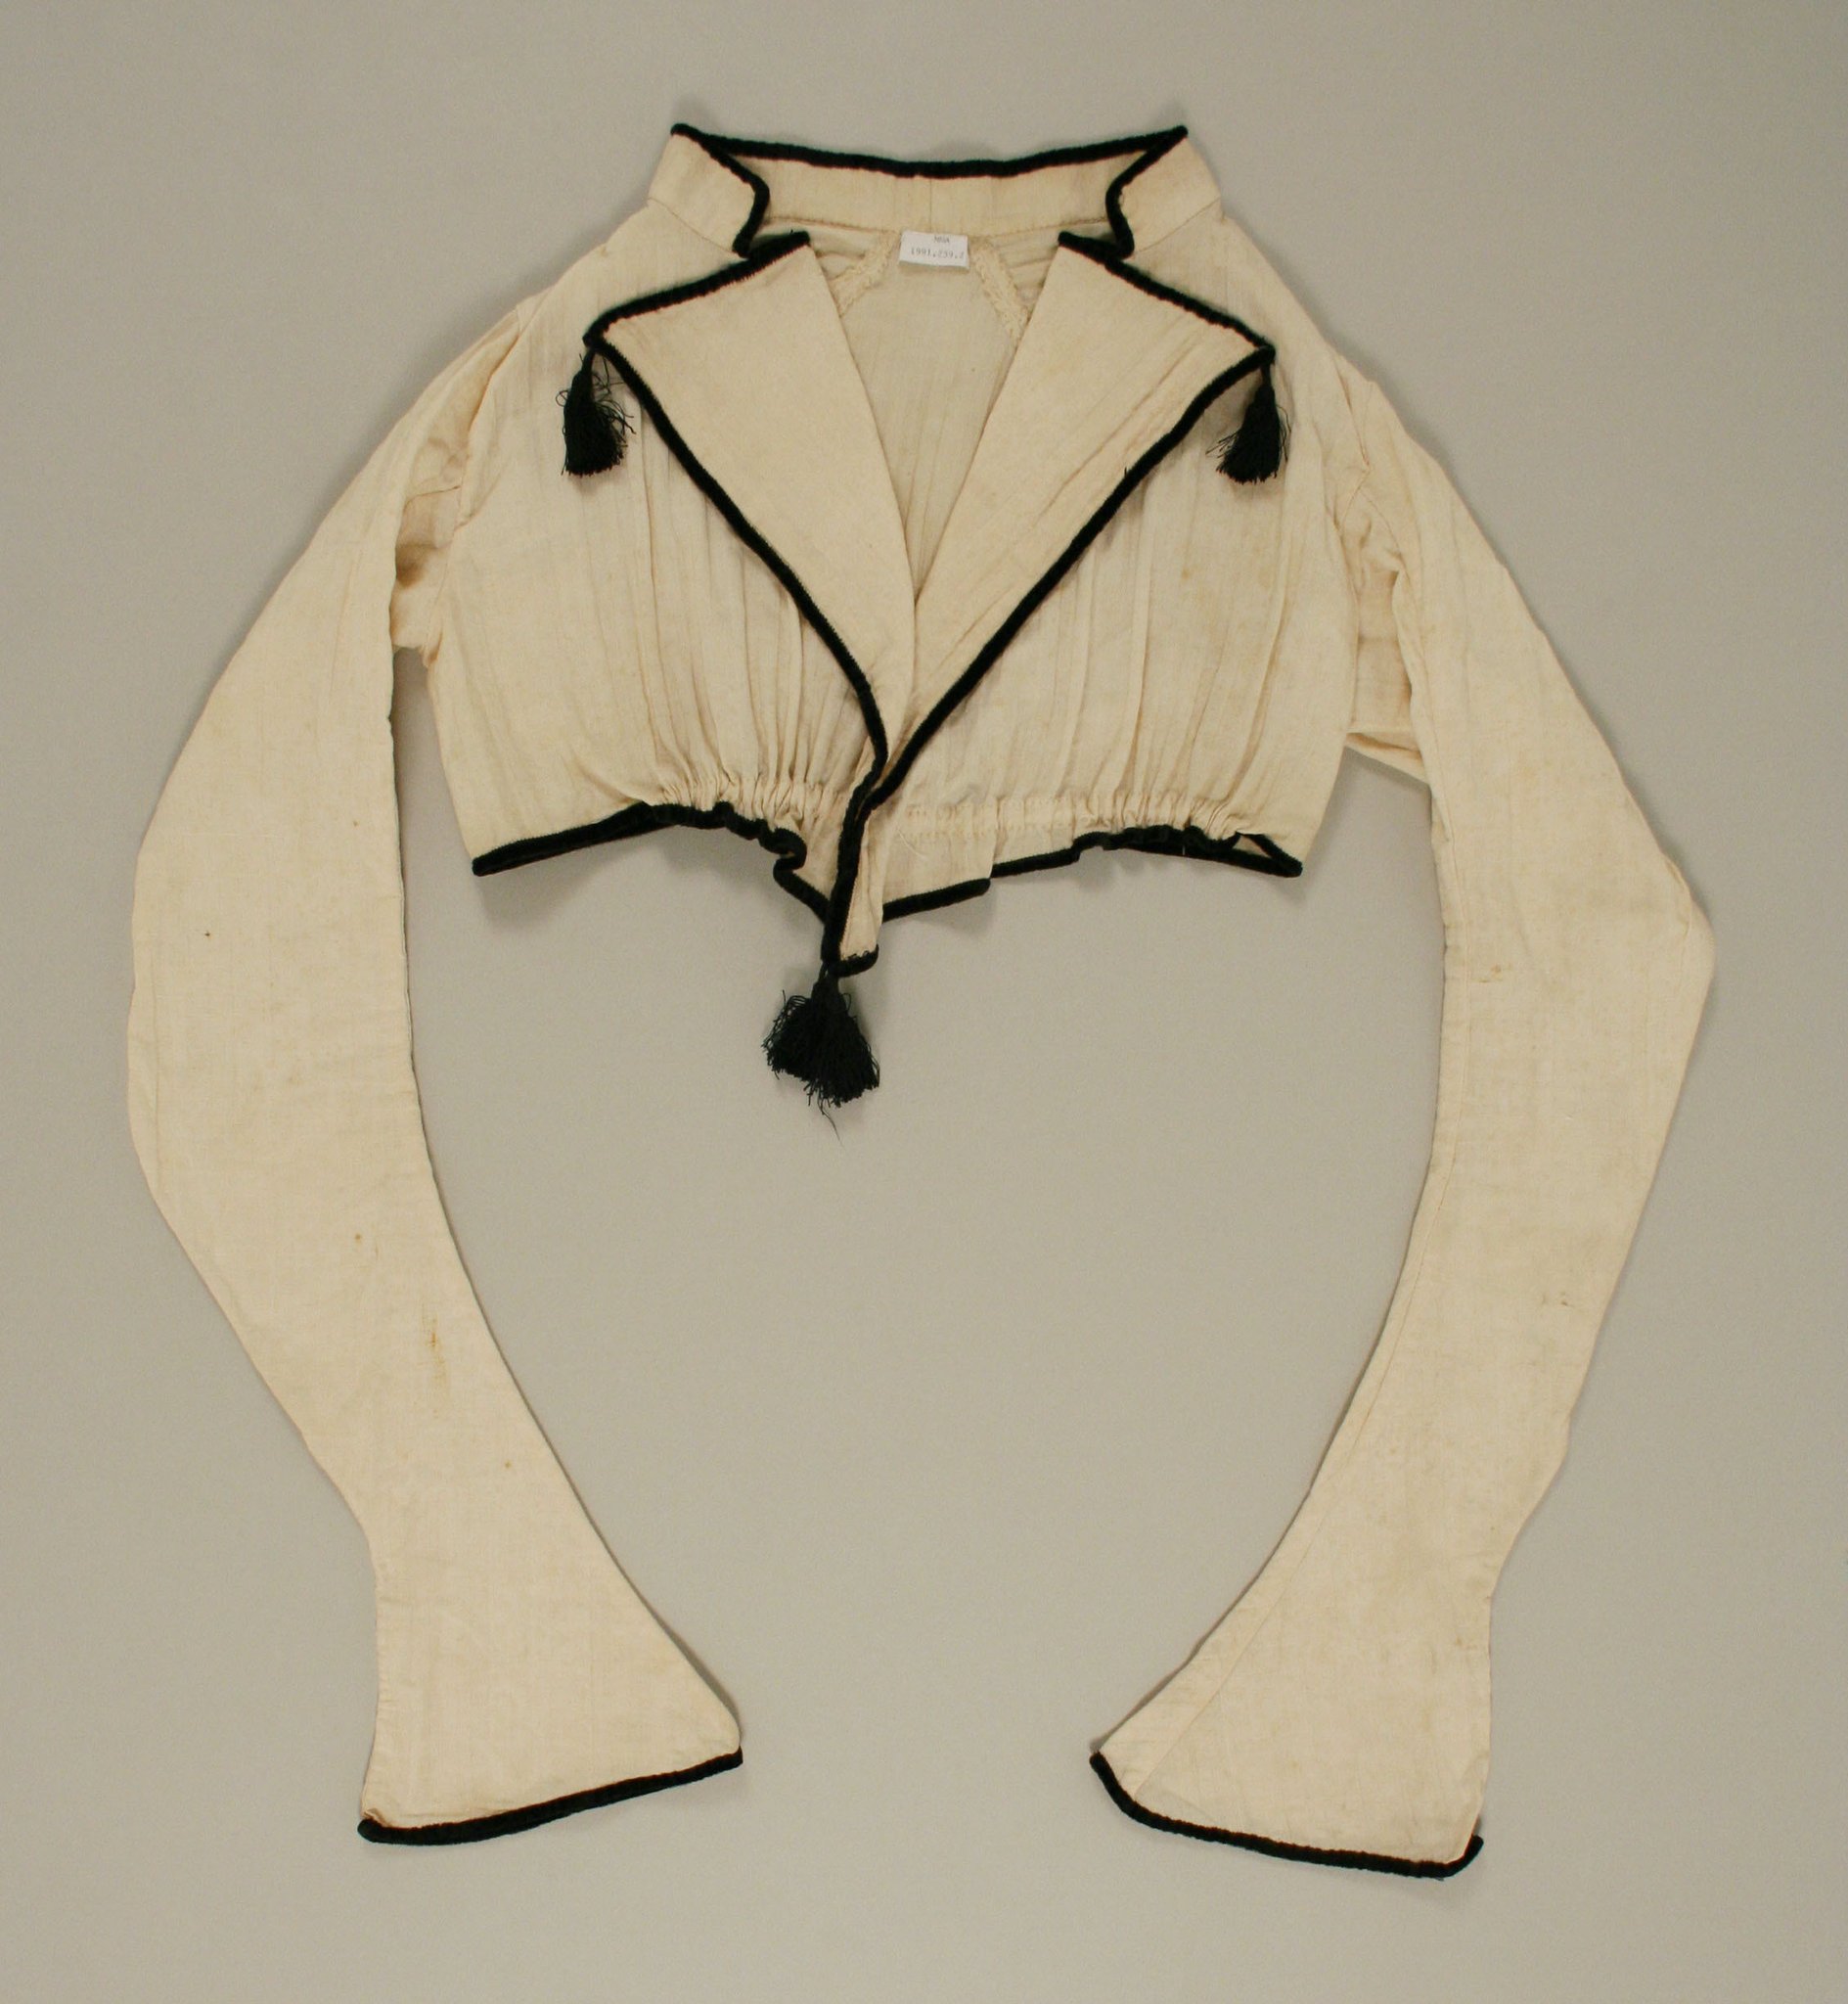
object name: spencer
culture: french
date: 1800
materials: silk